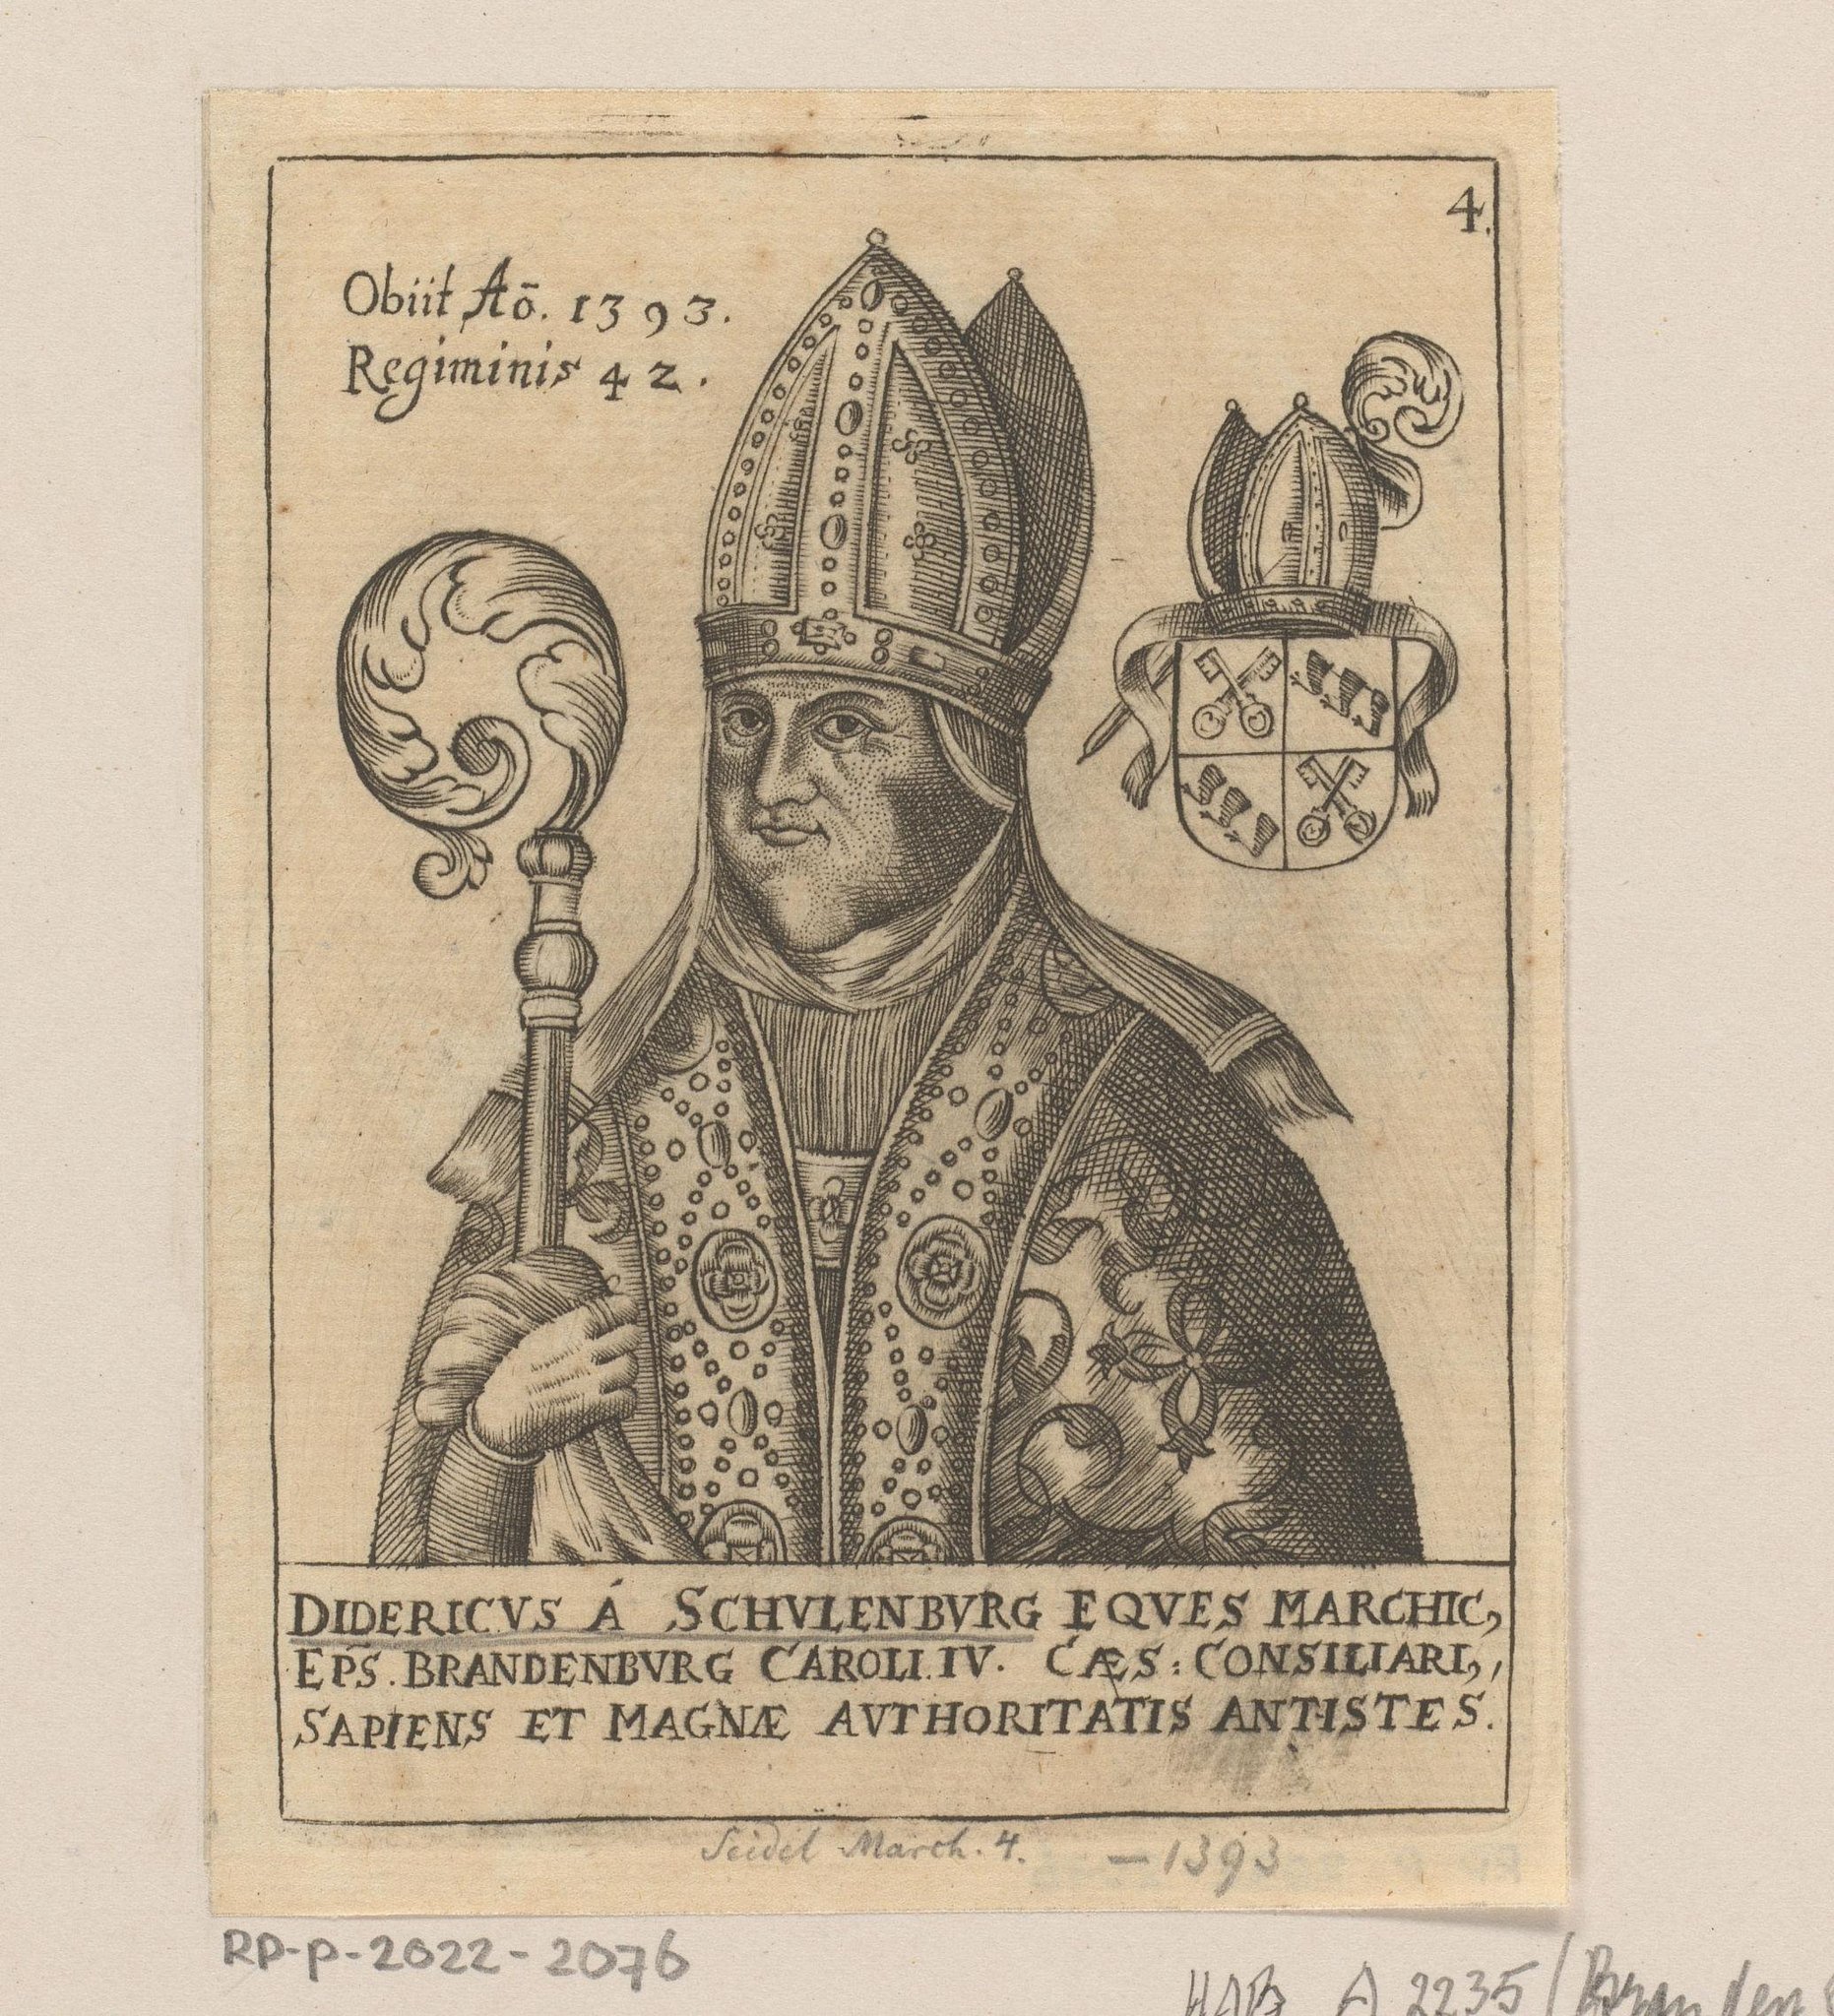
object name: print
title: Portret van Dietrich von der Schulenburg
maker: Anonymous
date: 1751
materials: paper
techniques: engraving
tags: archbishop, bishop, etc. (roman catholic), historical persons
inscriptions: inscription: ‘Seidel March. 4. - 1393’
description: De prent is uitgegeven als onderdeel van een serie. Later is de prent mogelijk ook als boekillustratie gebruikt in: Küster, Georg Gottfried. Martin Friedrich Seidels Bilder-Sammlung in welcher hundert, gröstentheils in der Mark Brandenburg (…). Berlijn: Buchladen bey der Real-Schule, 1751. Het is onduidelijk tot welke uitgave de huidige prent behoort.